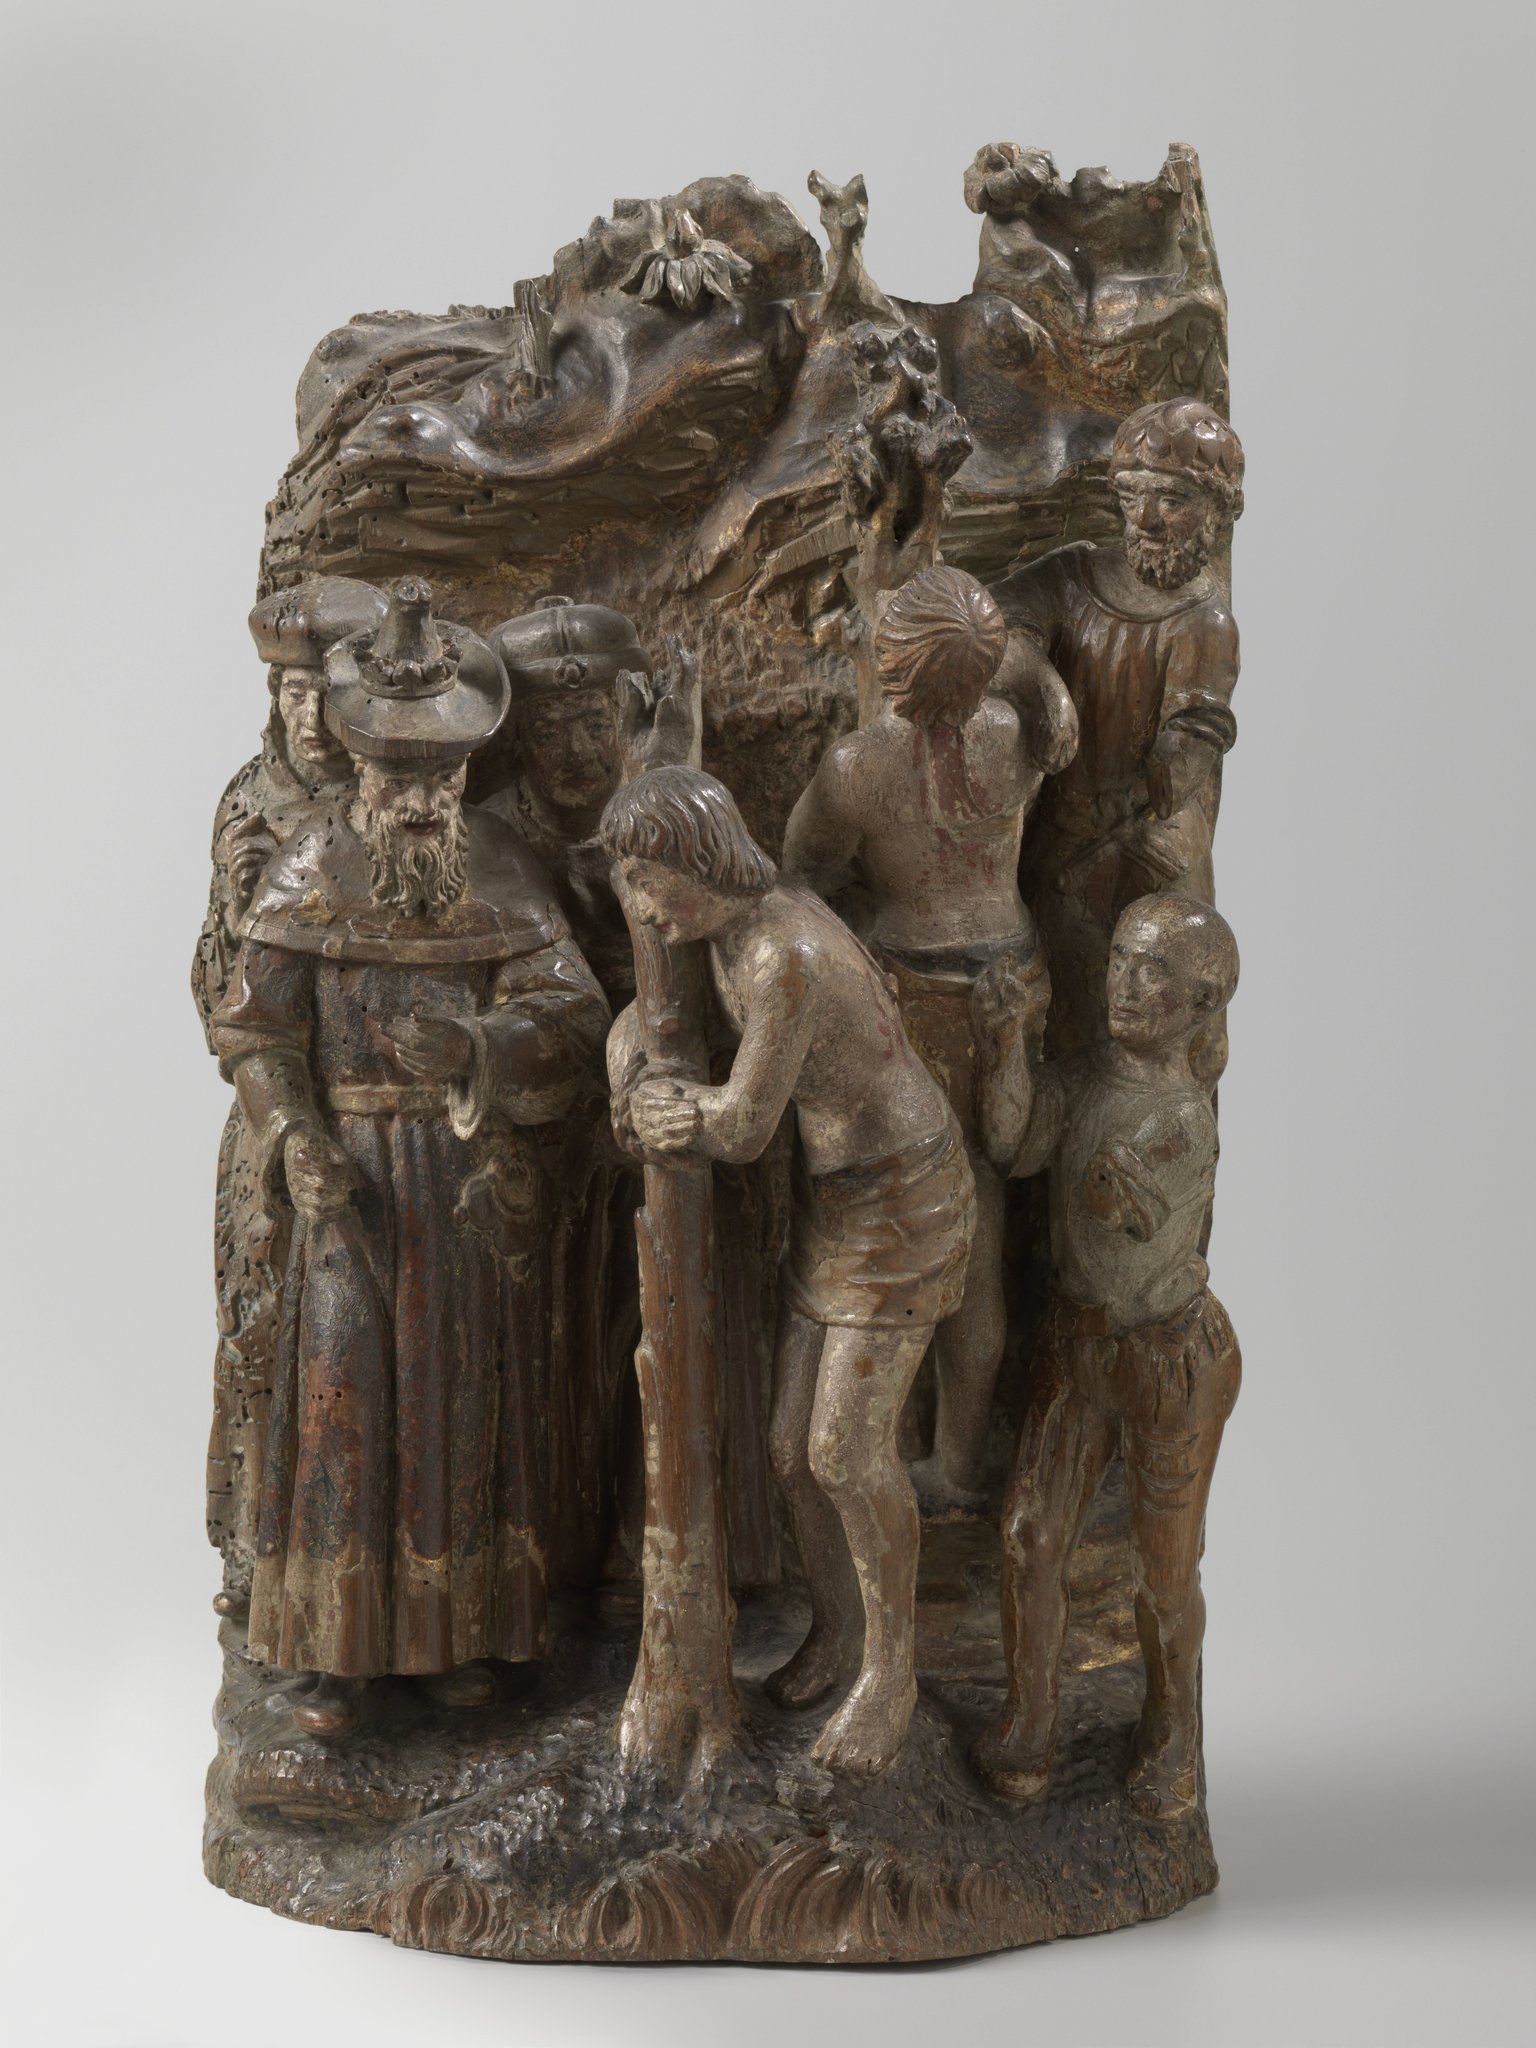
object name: figure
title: De marteldood van Crispinus en Crispinianus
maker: Anonymous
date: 1500-1525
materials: wood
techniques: polychromy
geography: northern france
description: Martyrdom of SS. Crispin and Crispianus. Walnut with remains of polychromy. Northern France, c. 1520.